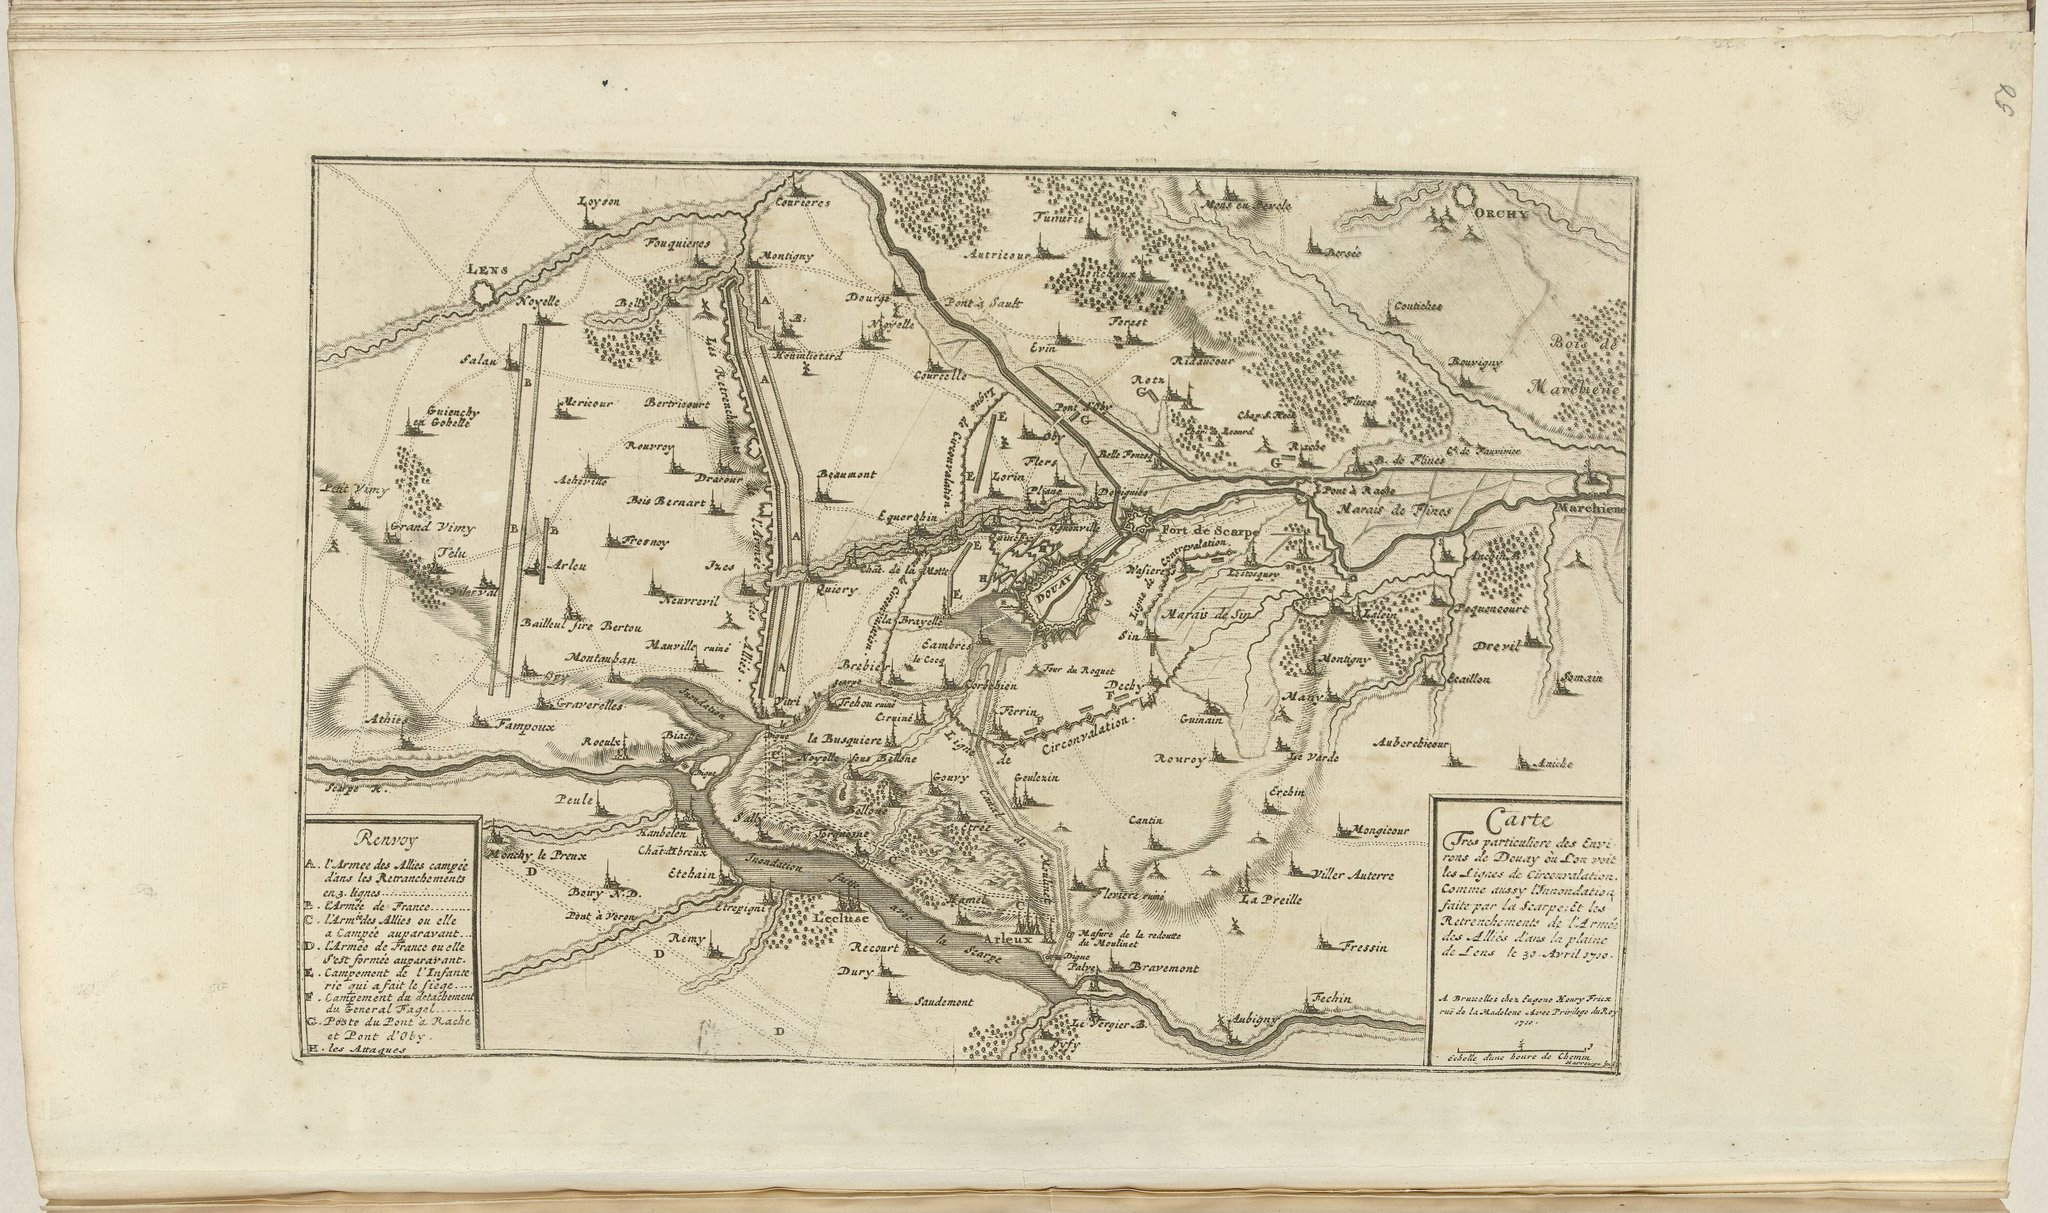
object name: print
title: Kaart van de omgeving van Douai, 1710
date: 1710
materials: paper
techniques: etching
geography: brussels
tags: maps of separate countries or regions, siege, position war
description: Kaart van de omgeving van Douai, met de omsingeling van de stad door de Geallieerden, 30 april 1710. Linksonder de legenda A-H in het Frans. Onderdeel van een gebundelde verzameling van plannen van veldslagen en steden vermaard in de Spaanse Successieoorlog.